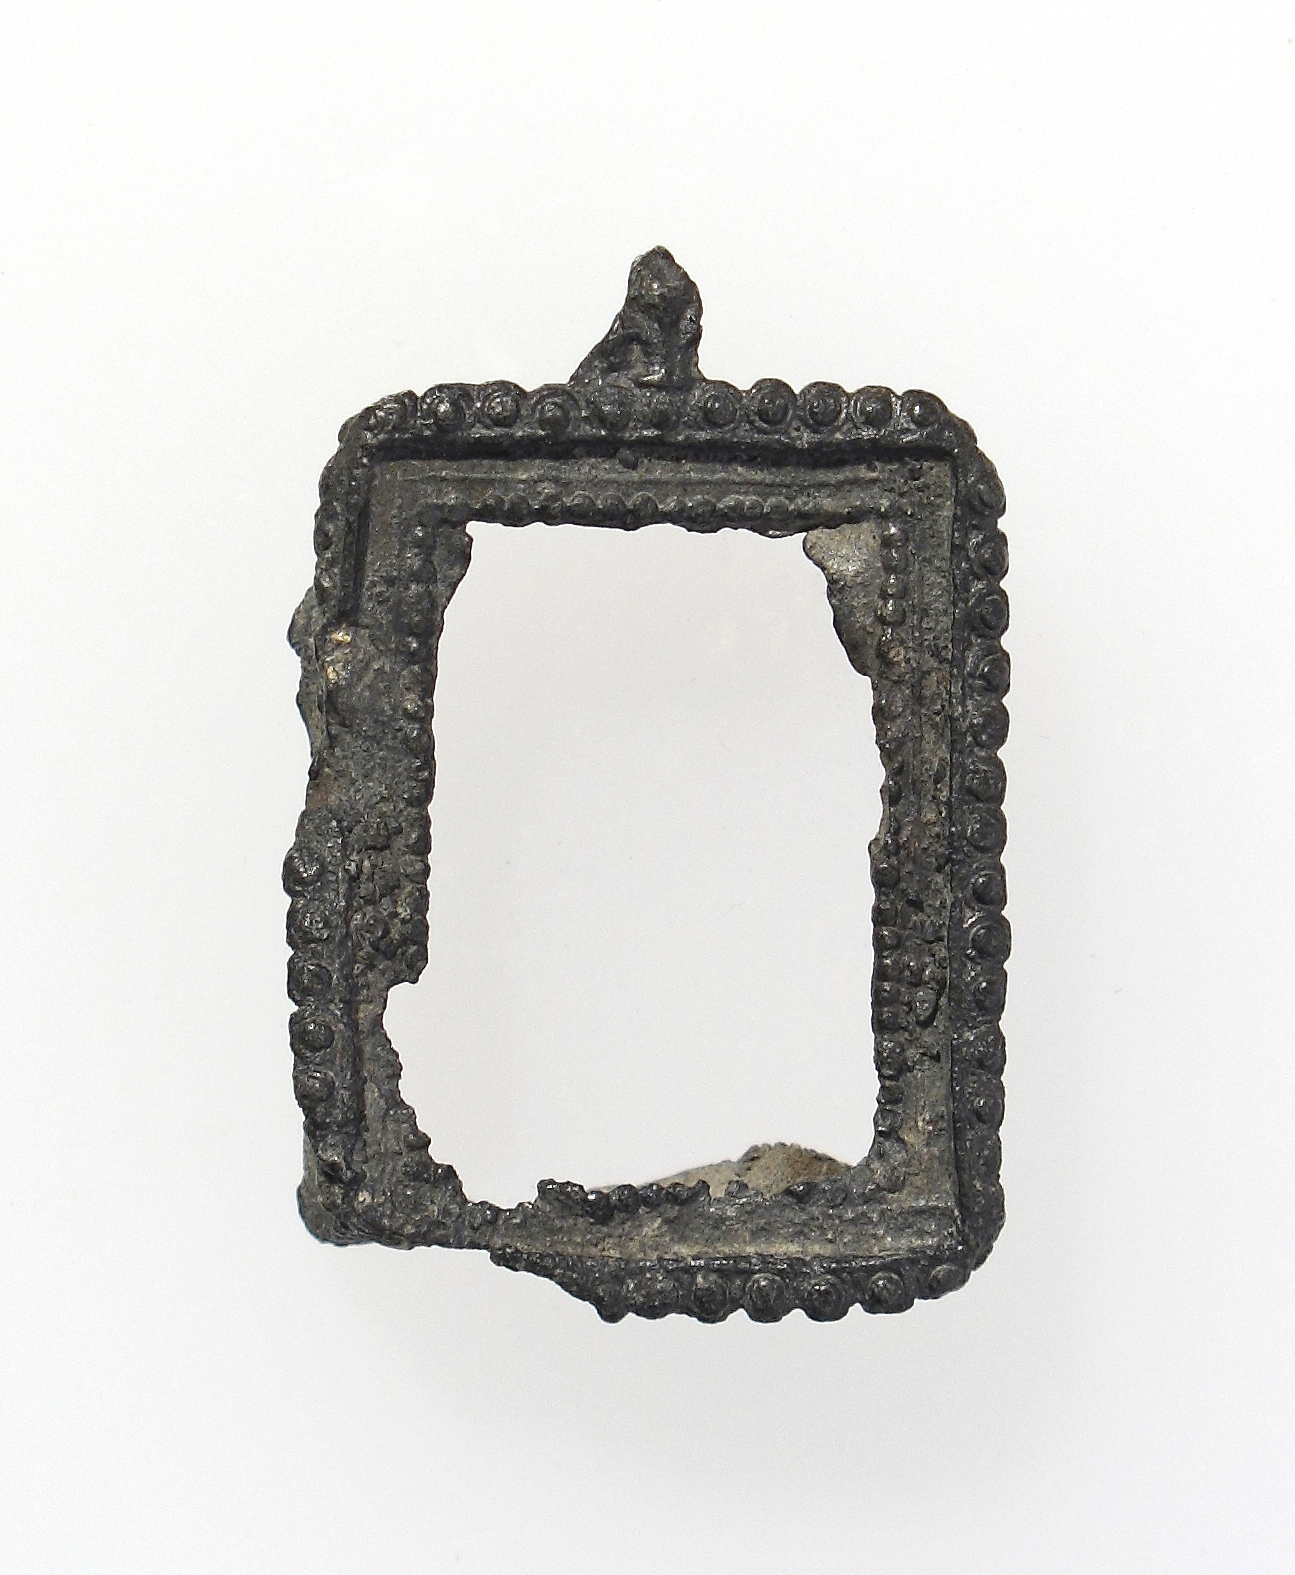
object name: pilgrim's badge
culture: french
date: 1301-1600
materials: lead